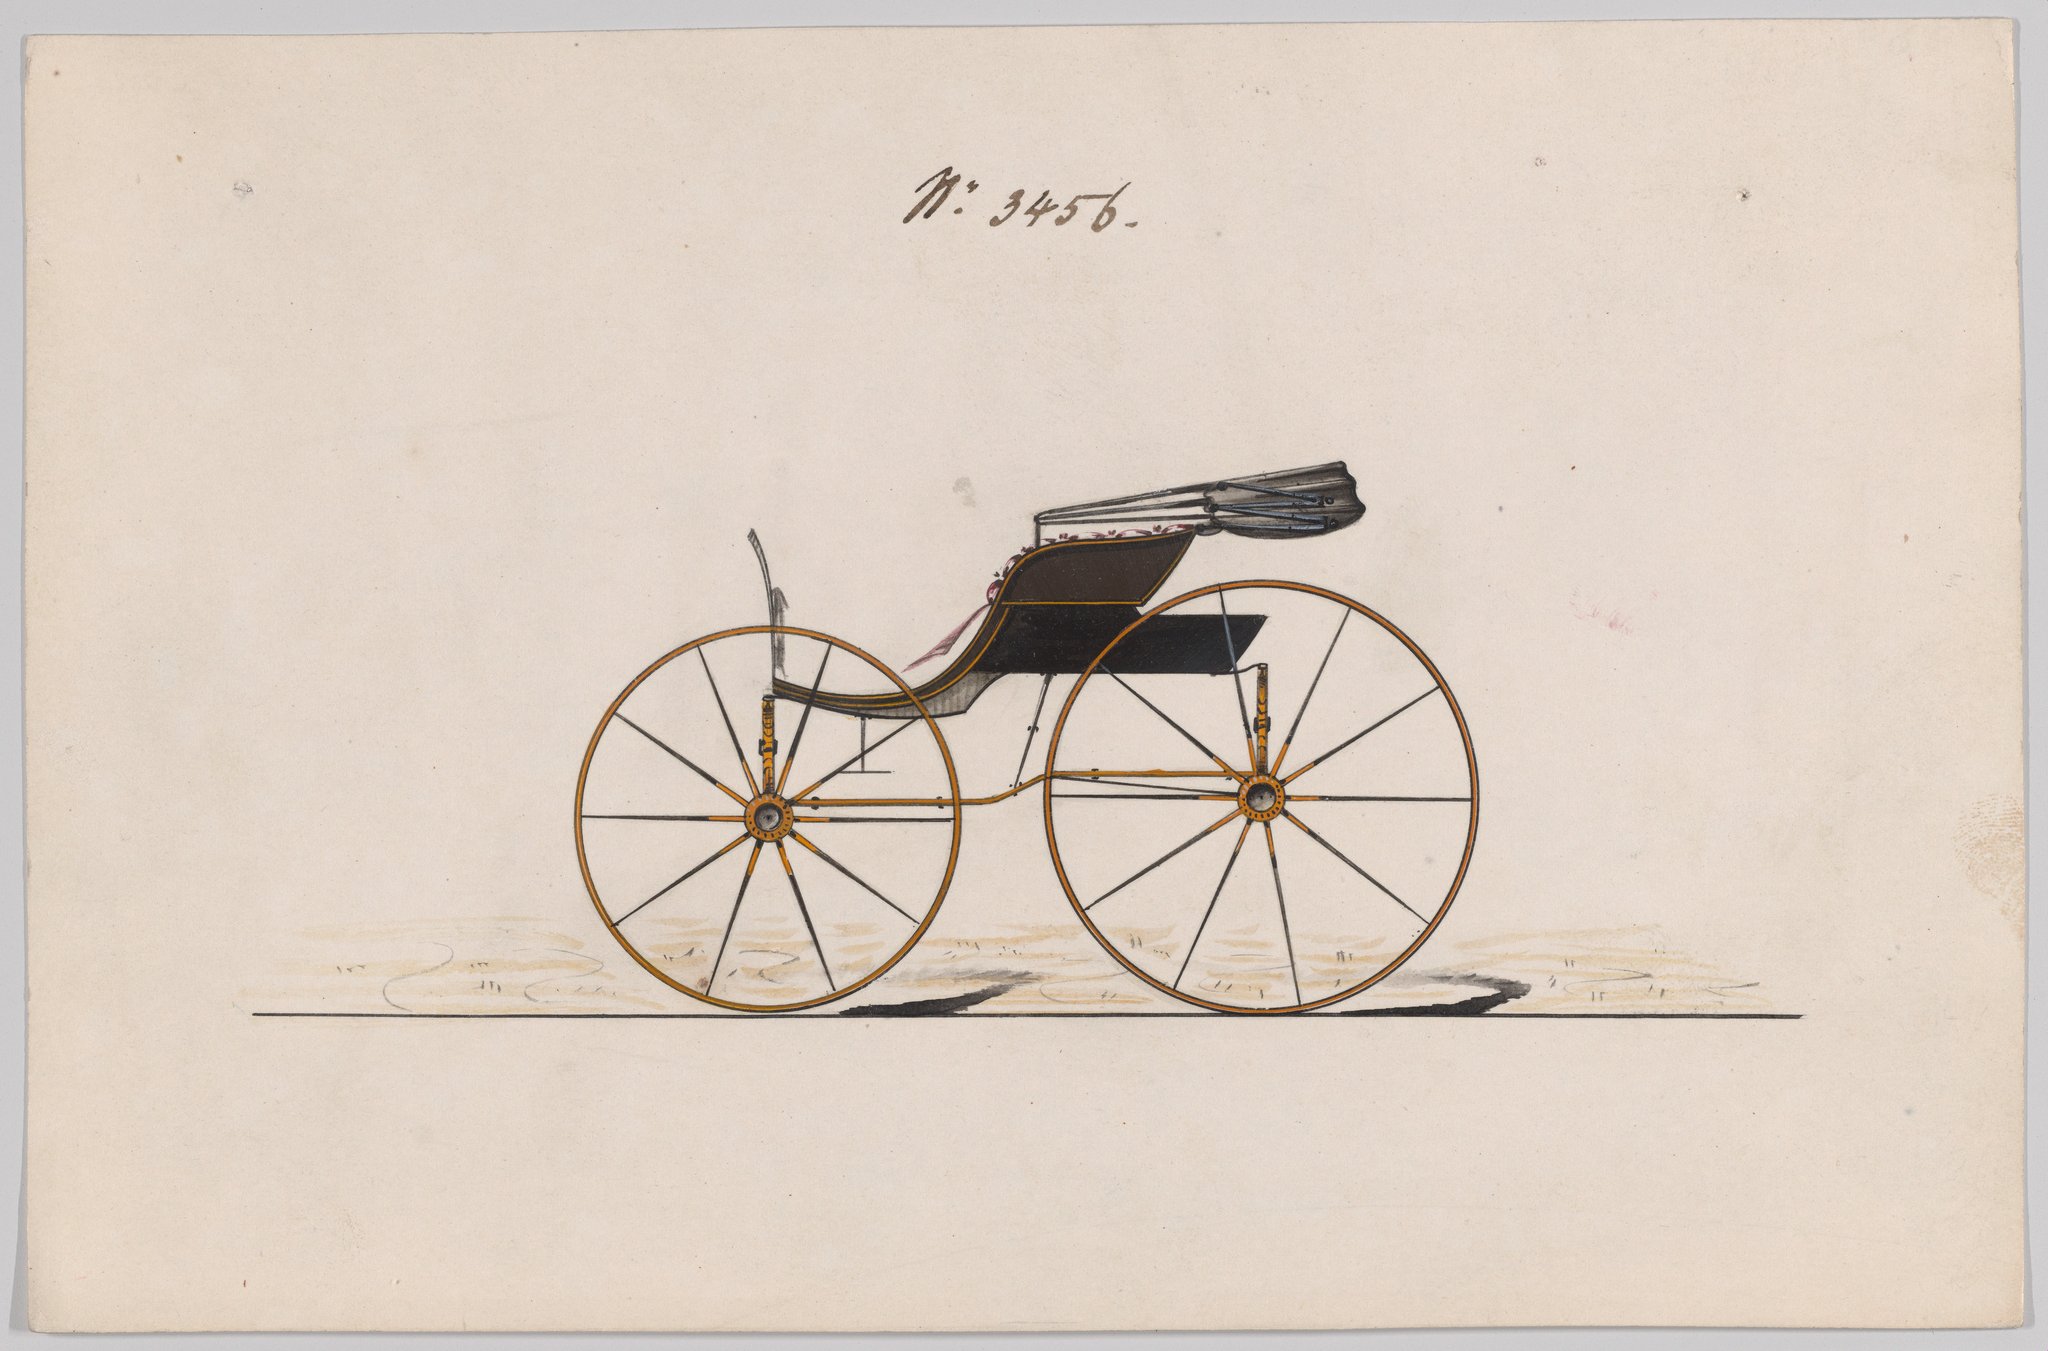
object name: drawing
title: Design for Pony Phaeton, no. 3456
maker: brewster & co.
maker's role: manufacturer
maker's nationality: american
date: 1878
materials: gouache, gum arabic, ink, watercolor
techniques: pen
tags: carriages